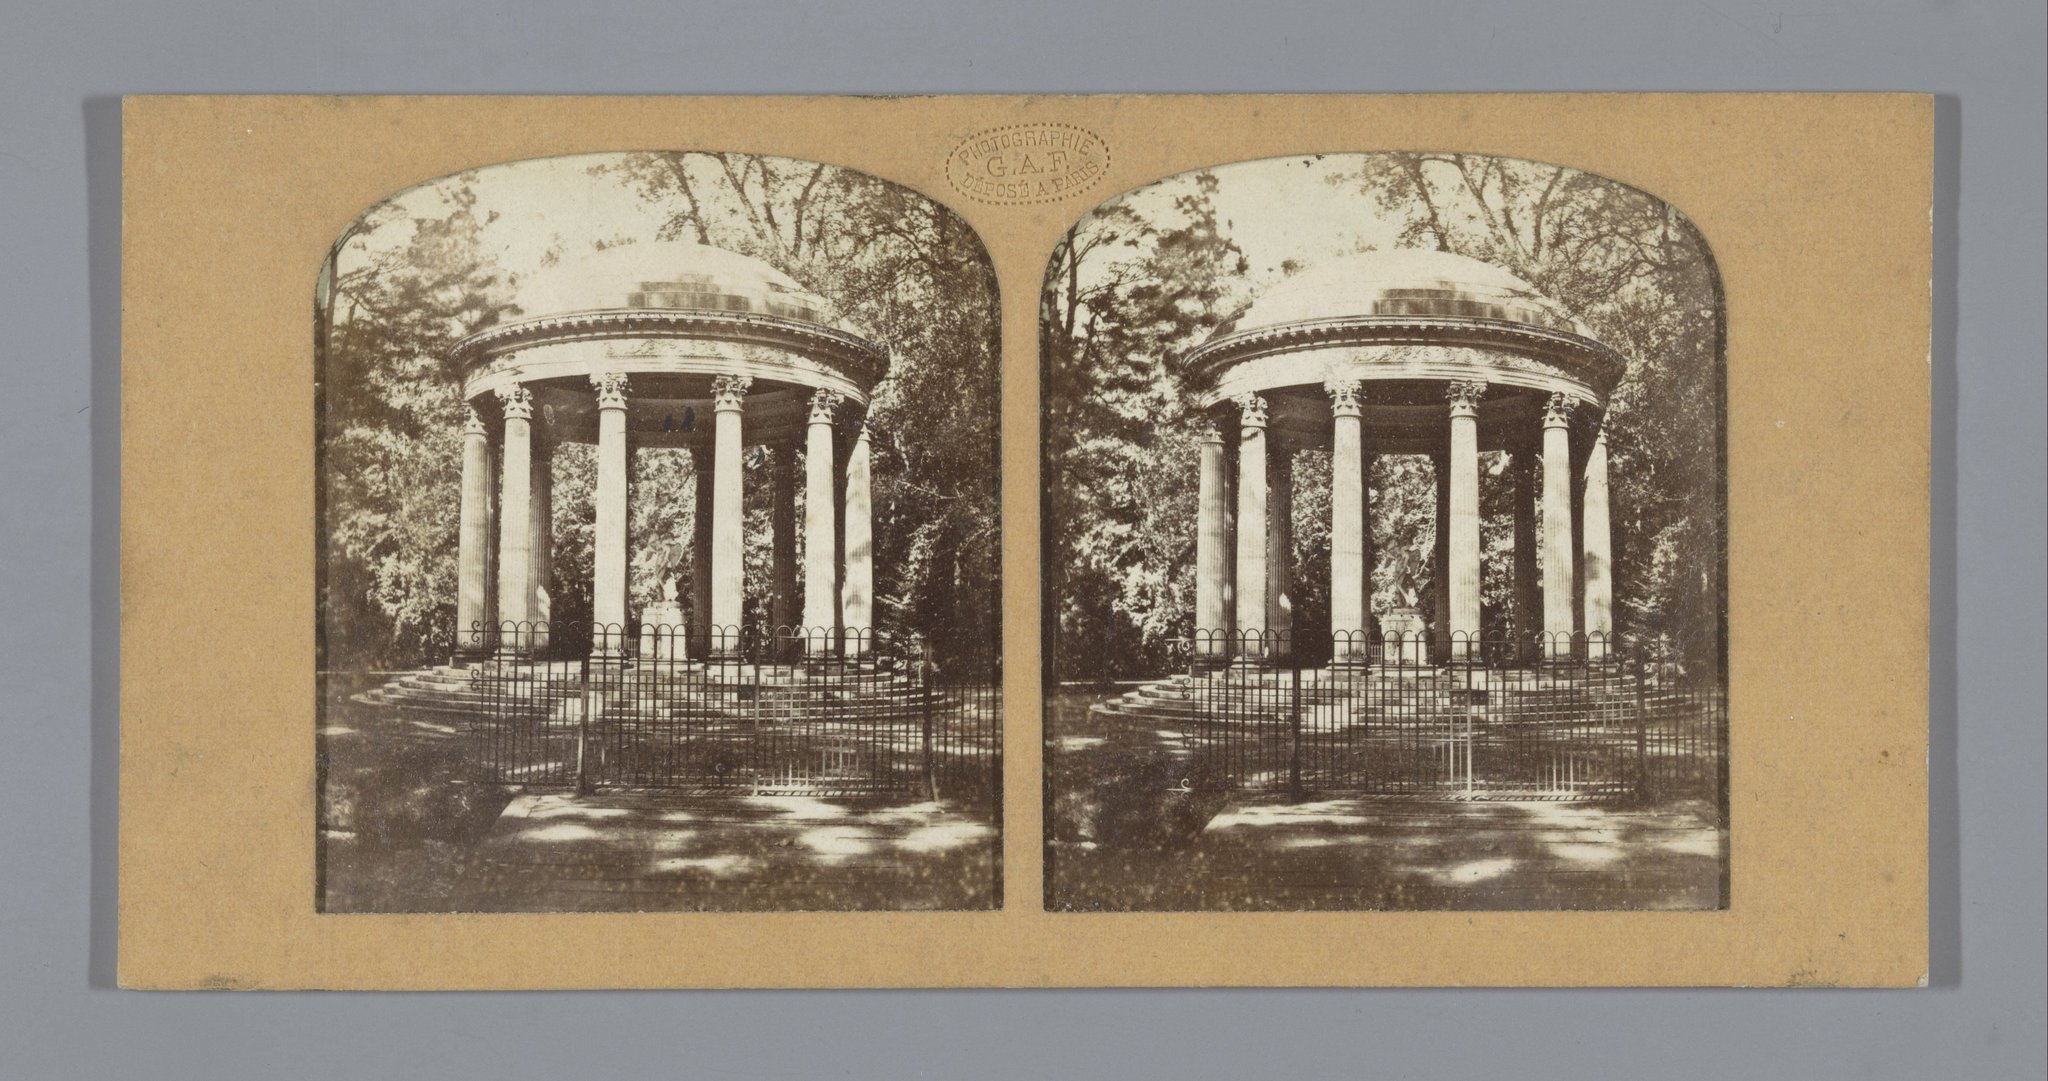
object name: tissue stereograph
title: Liefdestempel bij het Klein Trianon in de tuinen van Versailles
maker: florent grau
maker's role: manufacturer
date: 1859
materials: cardboard, paper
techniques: albumen print, hand coloring, perforating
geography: versailles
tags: column, pillar ~ architecture, french or architectonic garden; formal garden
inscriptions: inscription: ‘Déposé a Paris’